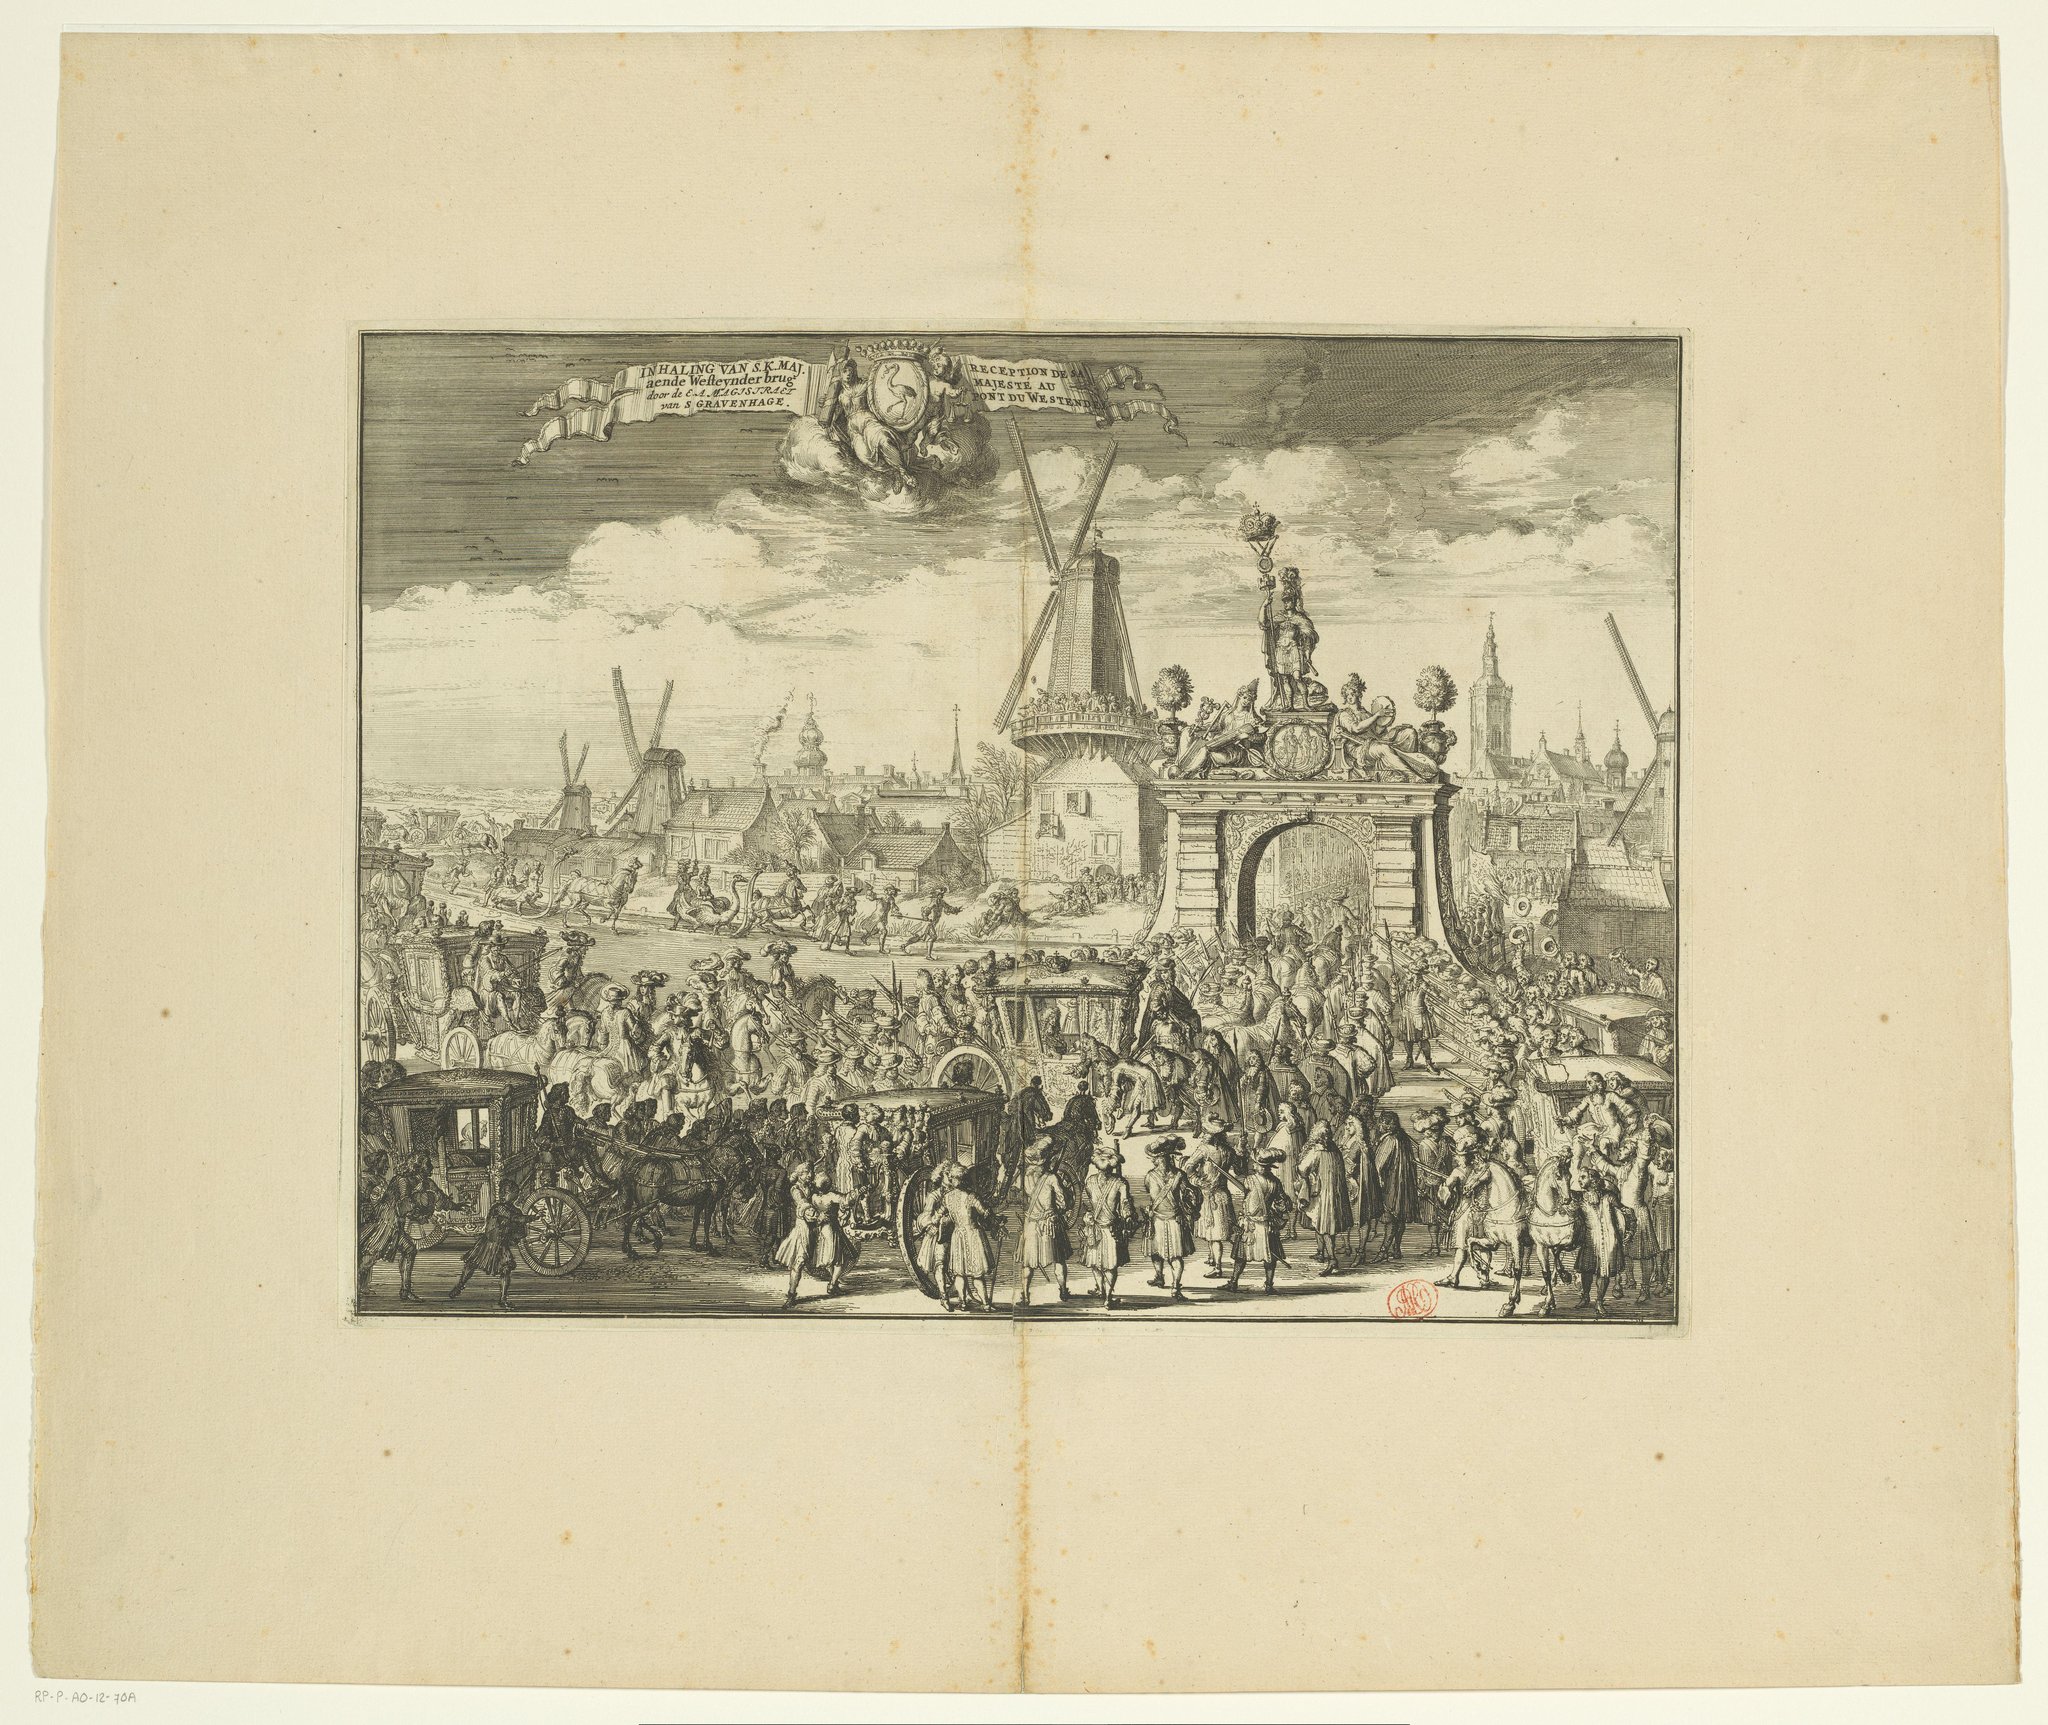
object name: print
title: Aankomst van Willem III bij de Westeinderbrug, 1691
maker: romeyn de hooghe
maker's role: draughtsman, goldsmith, painter, print maker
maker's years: 1645-1708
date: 1691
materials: paper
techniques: etching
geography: northern netherlands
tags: william iii (prince of orange and king of england, scotland, and ireland), triumphal entry and public reception, pageant, 'entrée solennelle', 'joyeuse entrée'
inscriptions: collector's mark: Lugt 195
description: Prent ook gebruikt in: Bidloo, Govard. Komste van zyne majesteit Willem III. Koning van Groot Britanje, enz. in Holland; ofte omstandelyke beschryving van alles, (…) vercierd met kopere plaaten. Den Haag: Arnoud Leers, 1691. Zie RP-P-1926-653 voor eerdere staat. Zie RP-P-OB-76.292 voor zelfde staat.